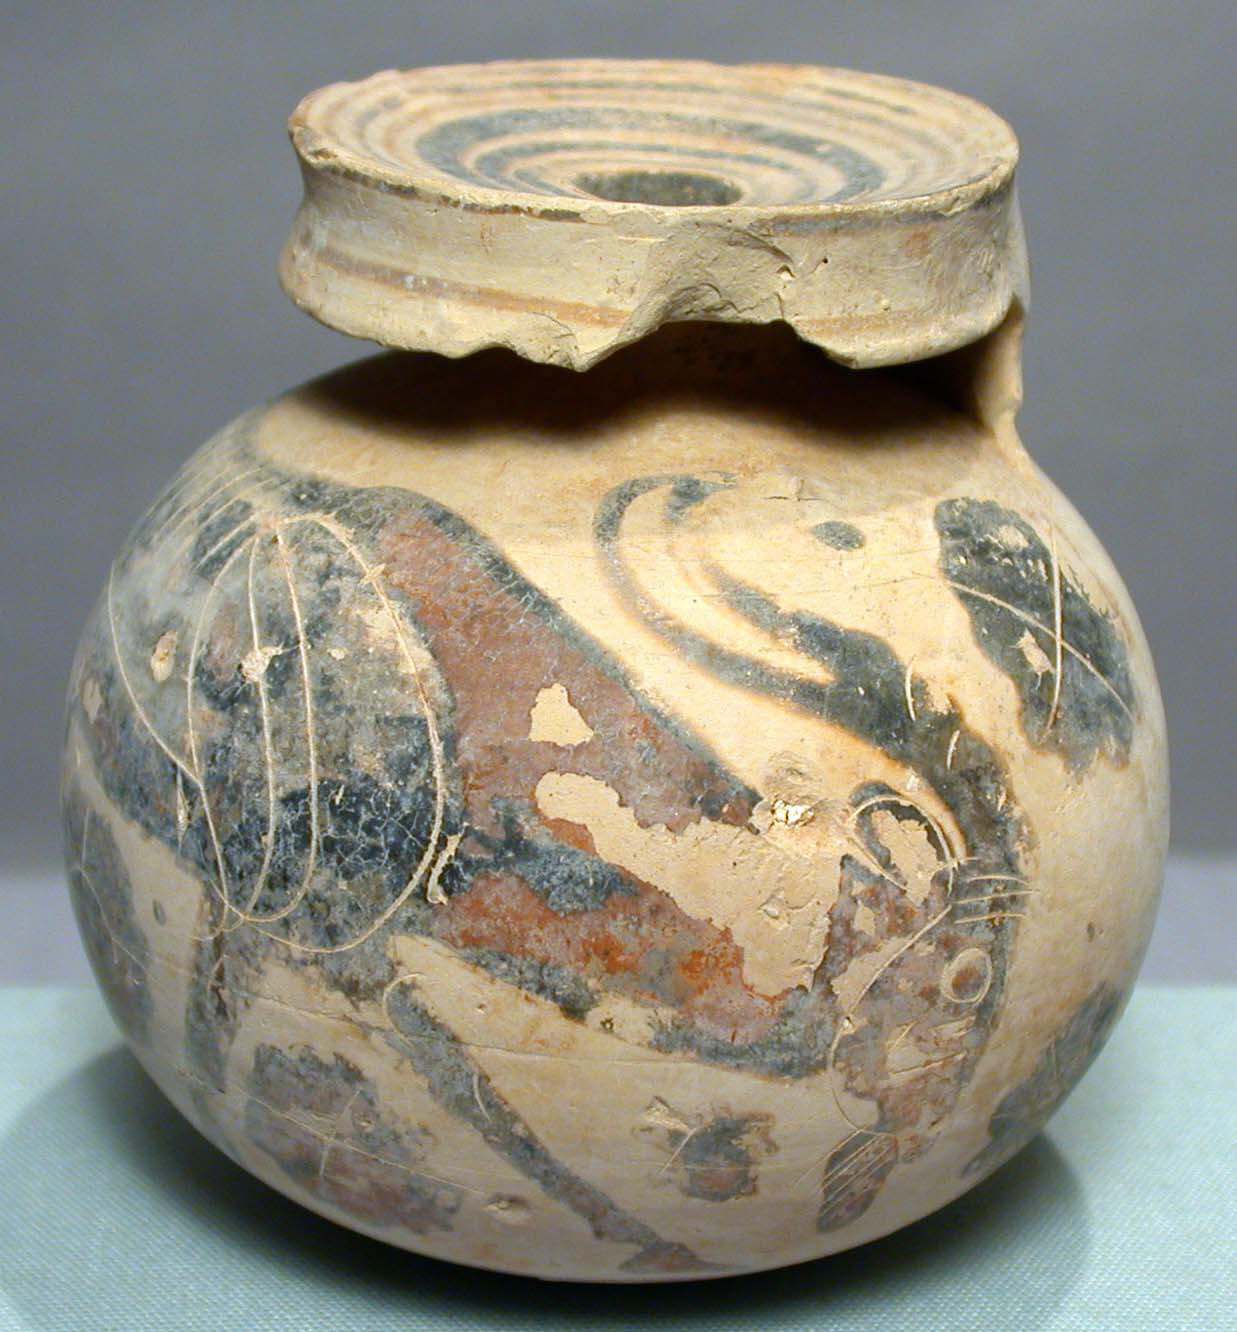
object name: aryballos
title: Terracotta aryballos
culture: greek, corinthian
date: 620-590 BCE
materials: terracotta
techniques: painting